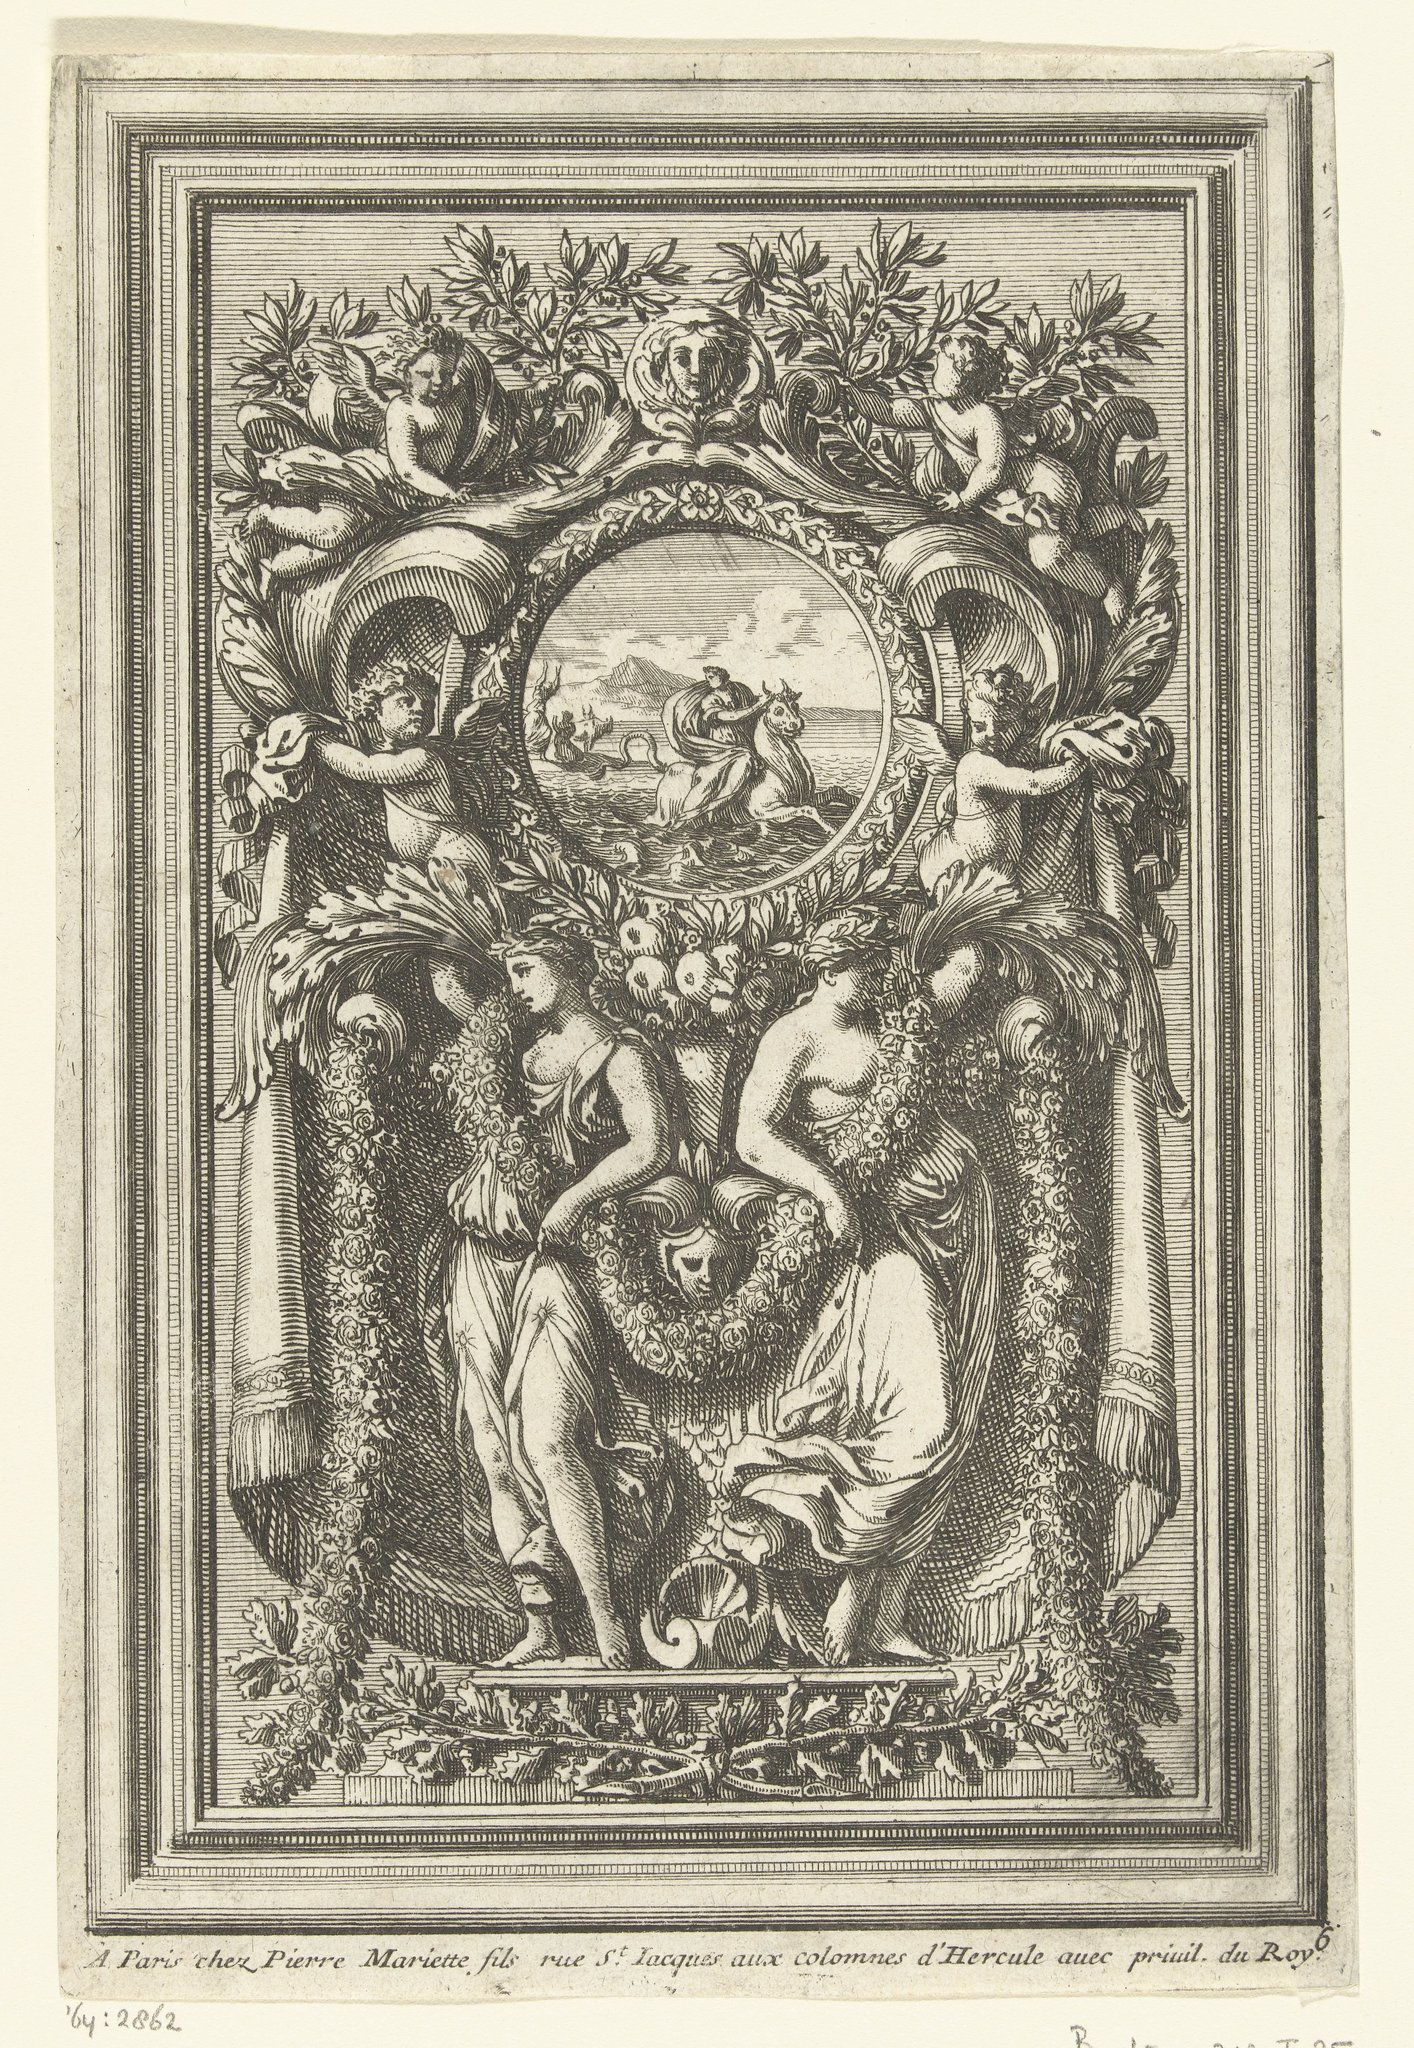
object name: print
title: Ornemens de Paneaux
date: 1655-1657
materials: paper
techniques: etching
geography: france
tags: jupiter, usually in the shape of a white bull, abducts europa and carries her across the water